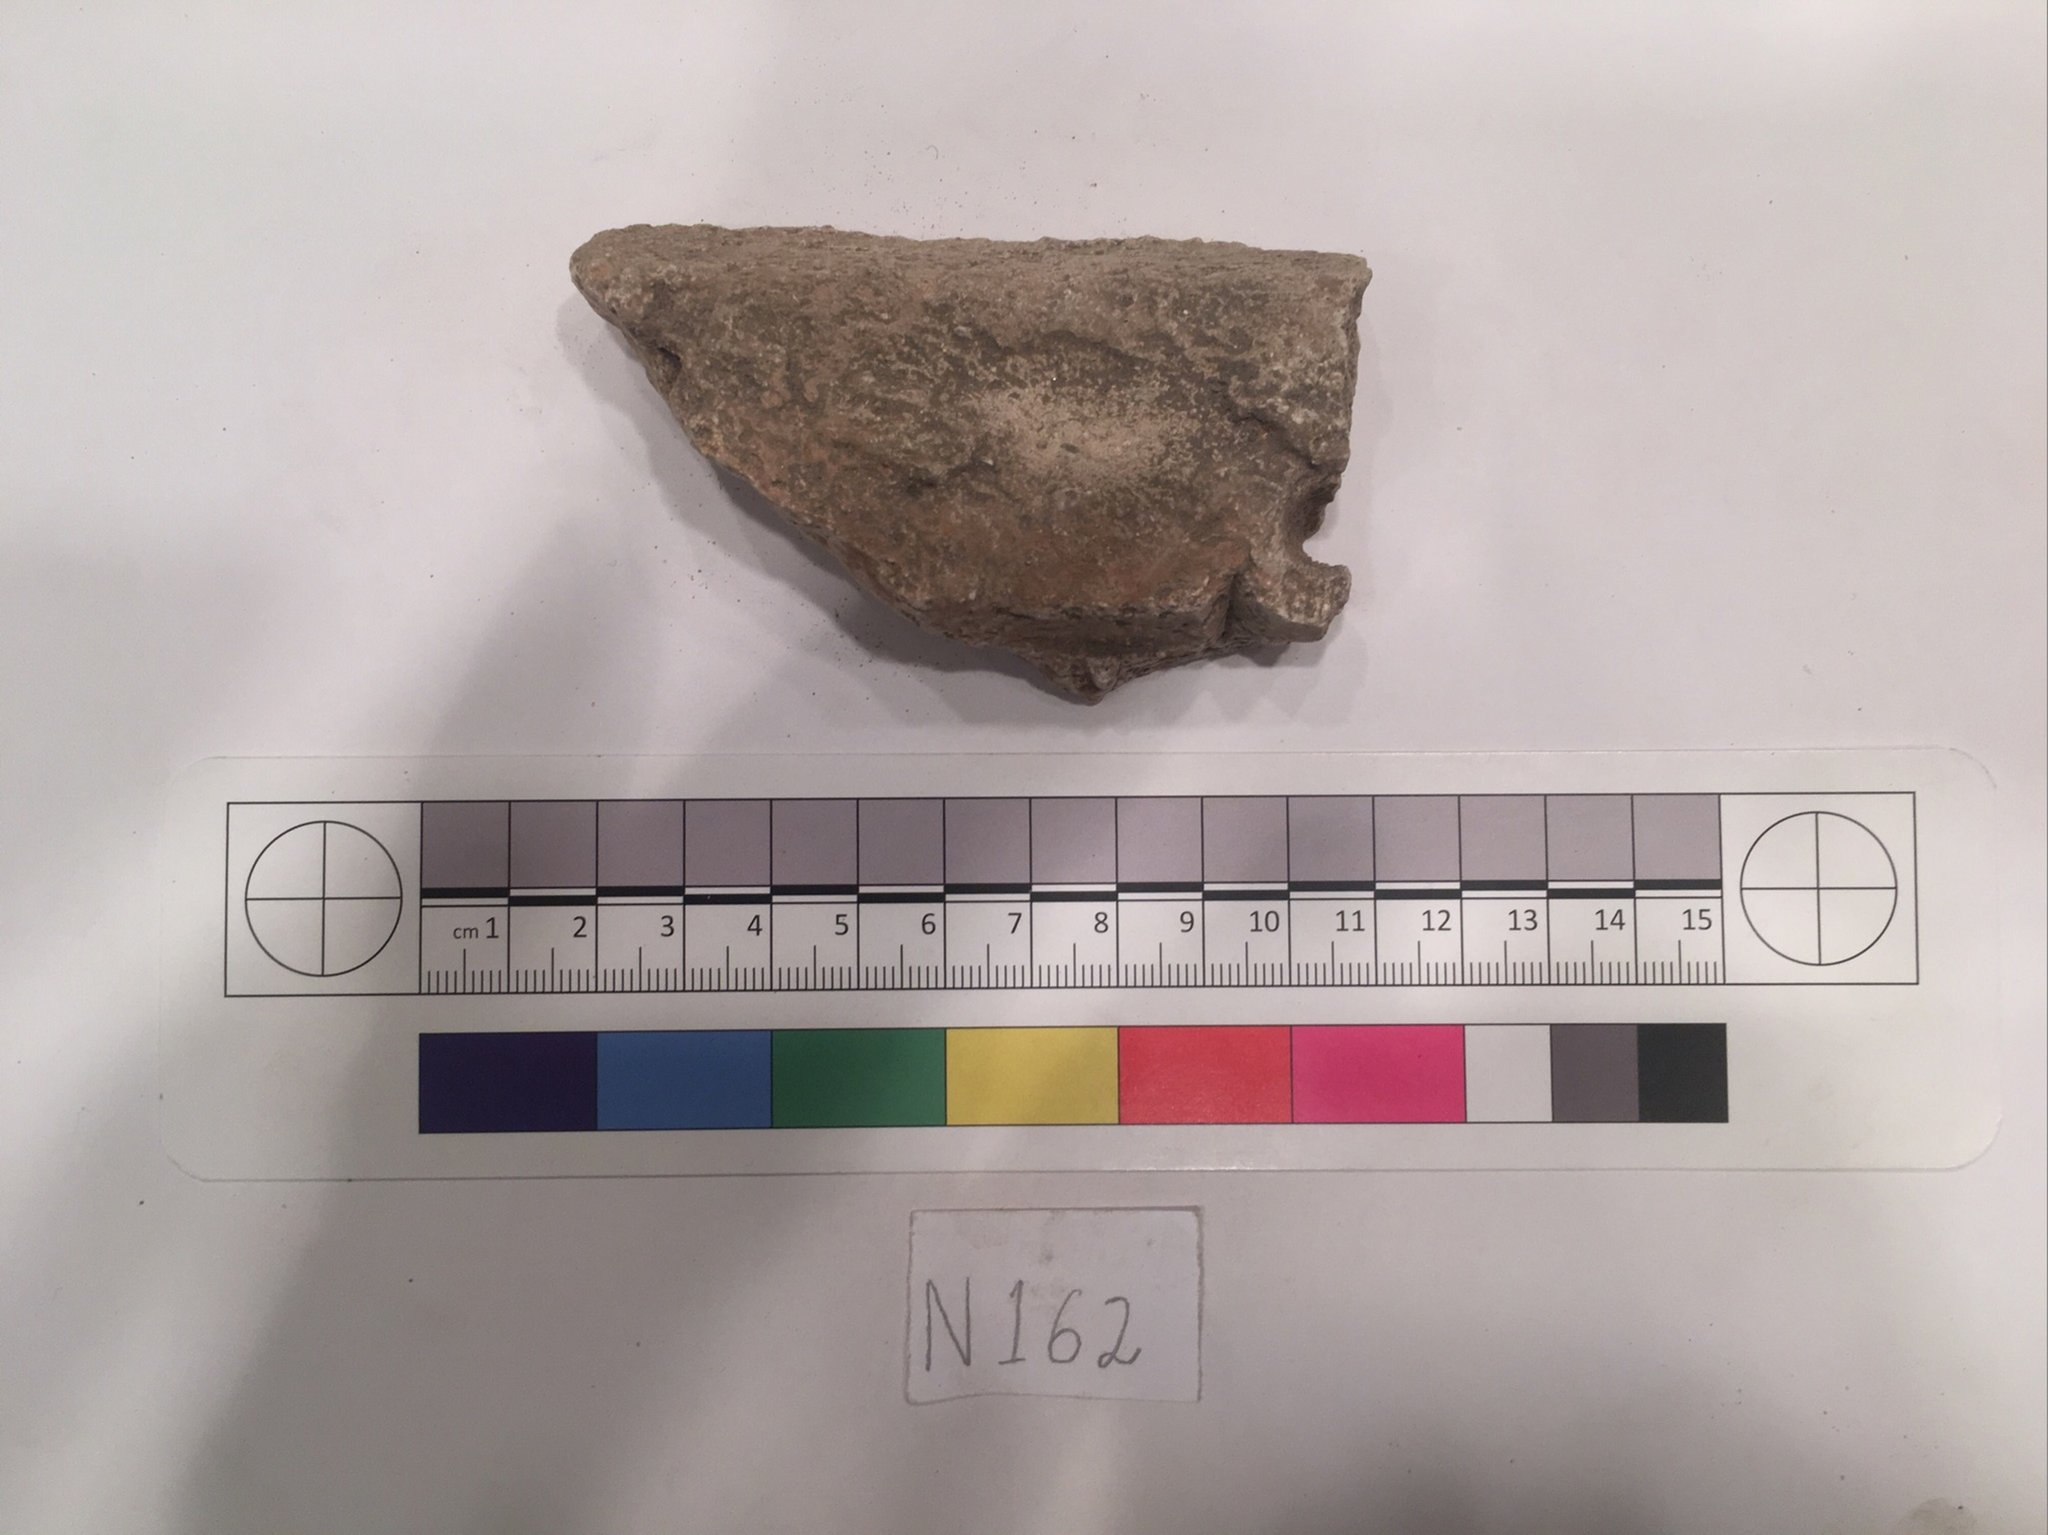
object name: fragment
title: Stucco Fragment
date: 701-1200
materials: plaster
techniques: carving, painting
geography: iran